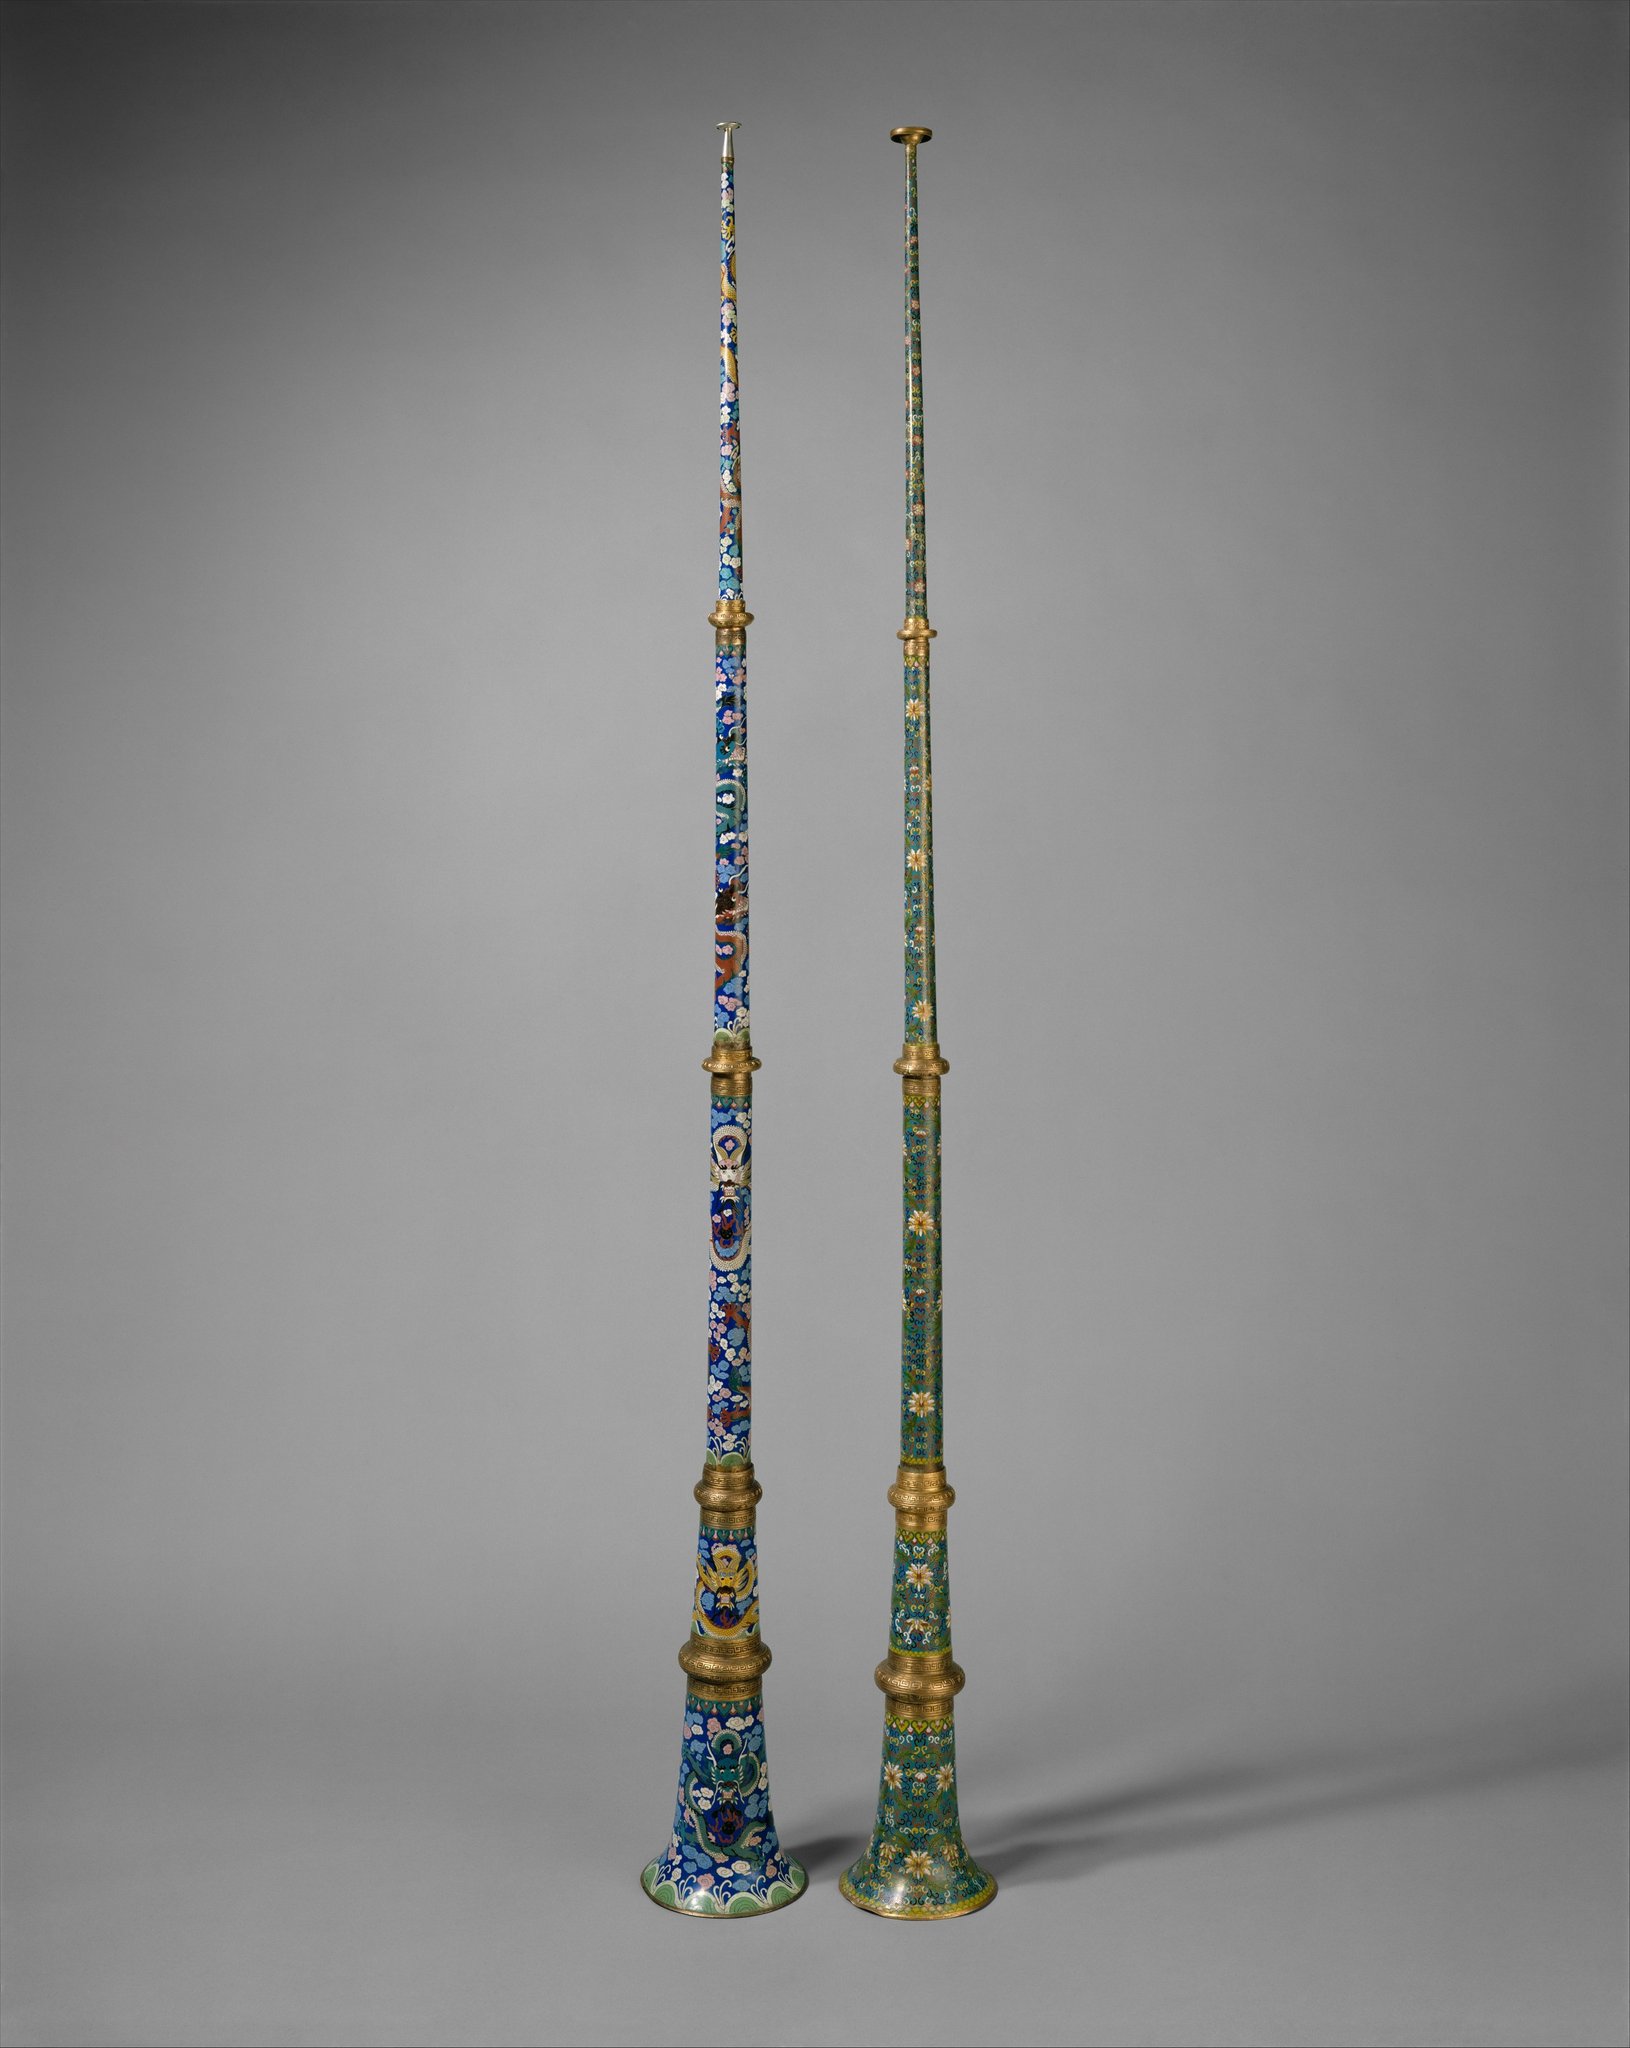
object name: dung chen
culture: chinese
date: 1368-1644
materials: brass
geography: china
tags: dragons